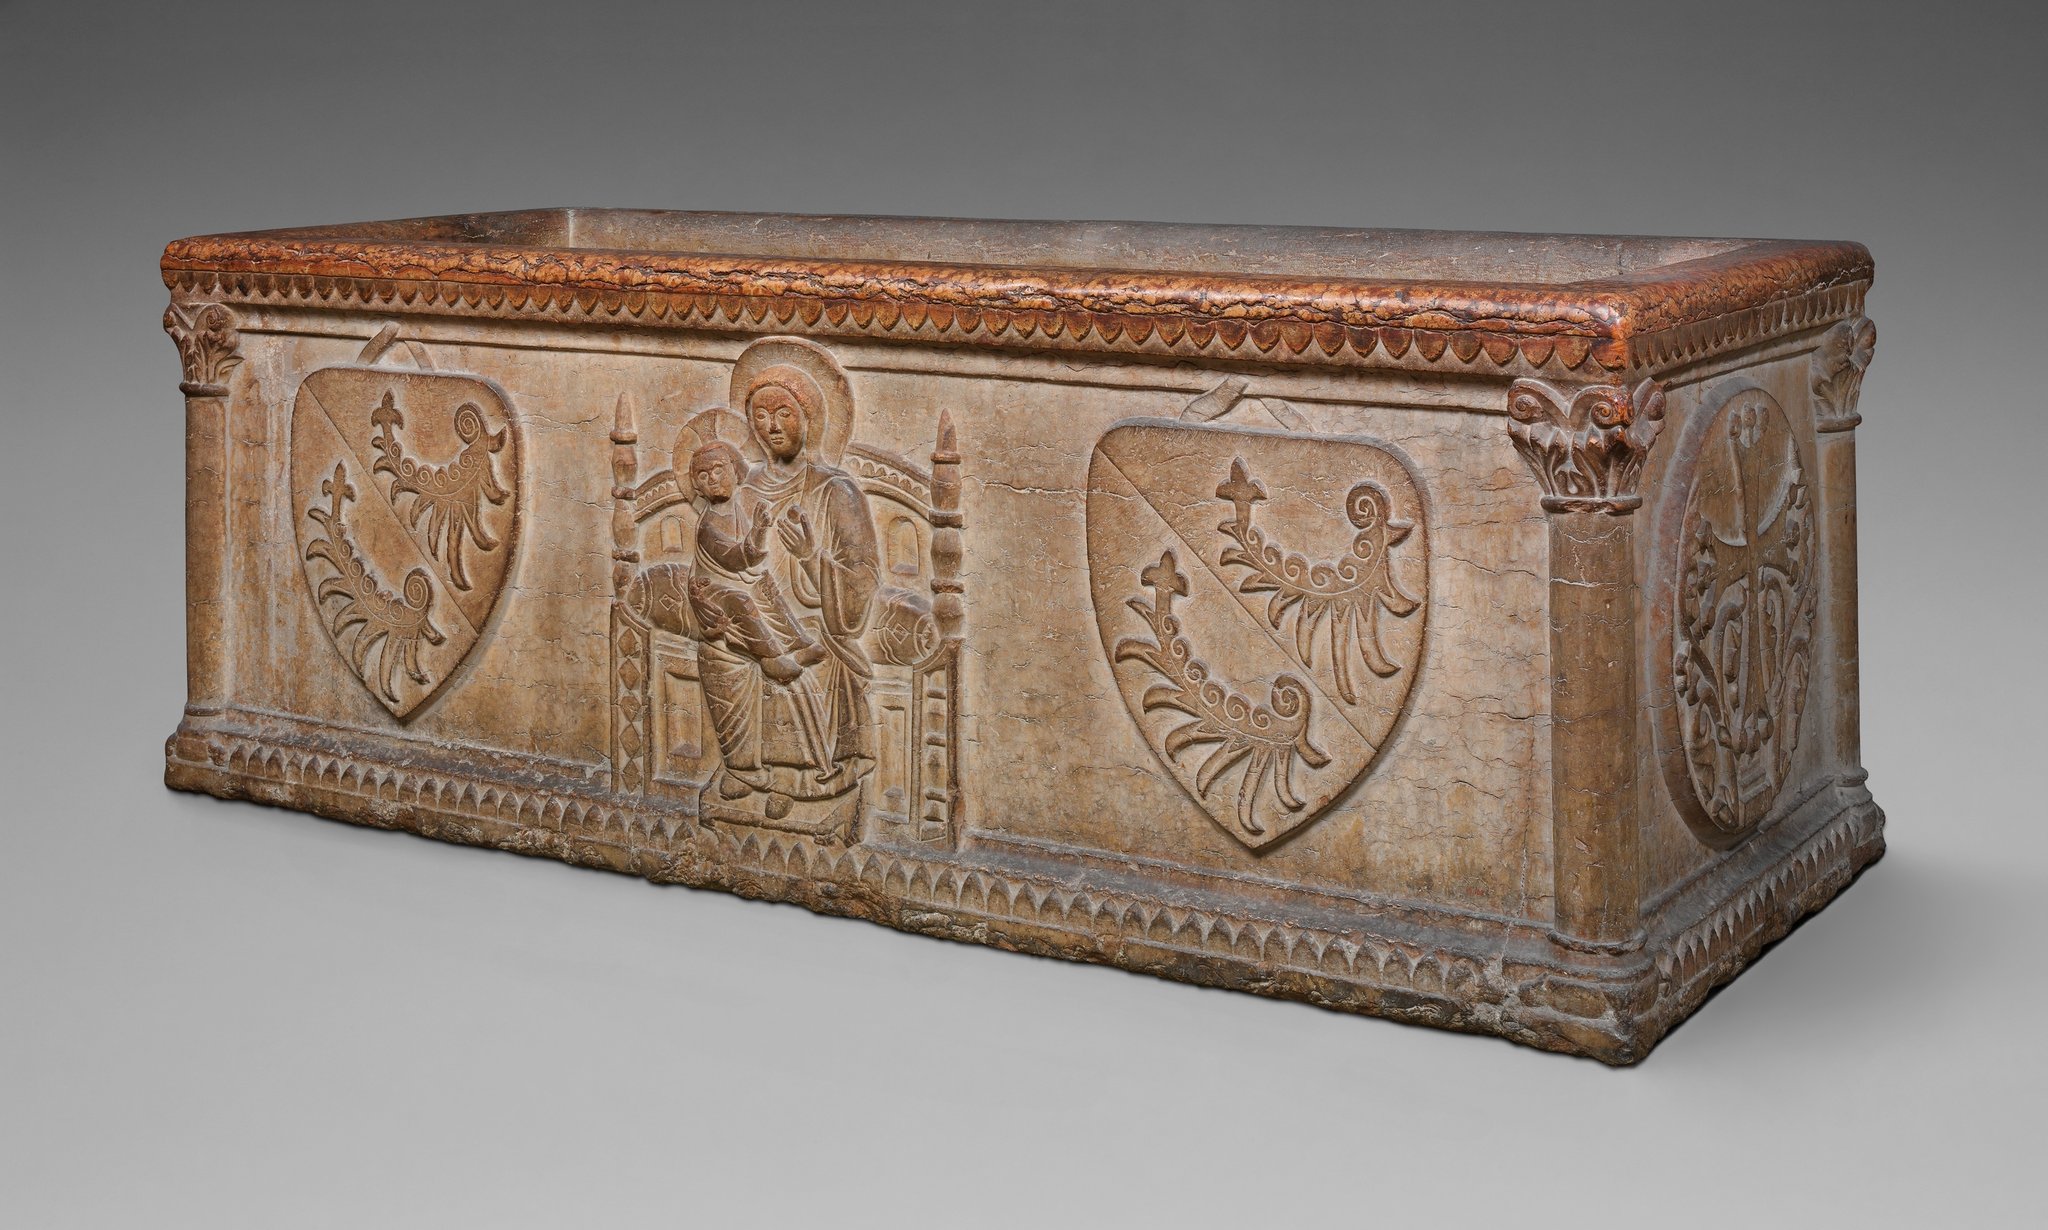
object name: sarcophagus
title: Sarcophagus with Virgin and Child and the Arms of the Sanguinacci Family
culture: north italian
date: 1267-1333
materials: limestone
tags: madonna and child,insignia